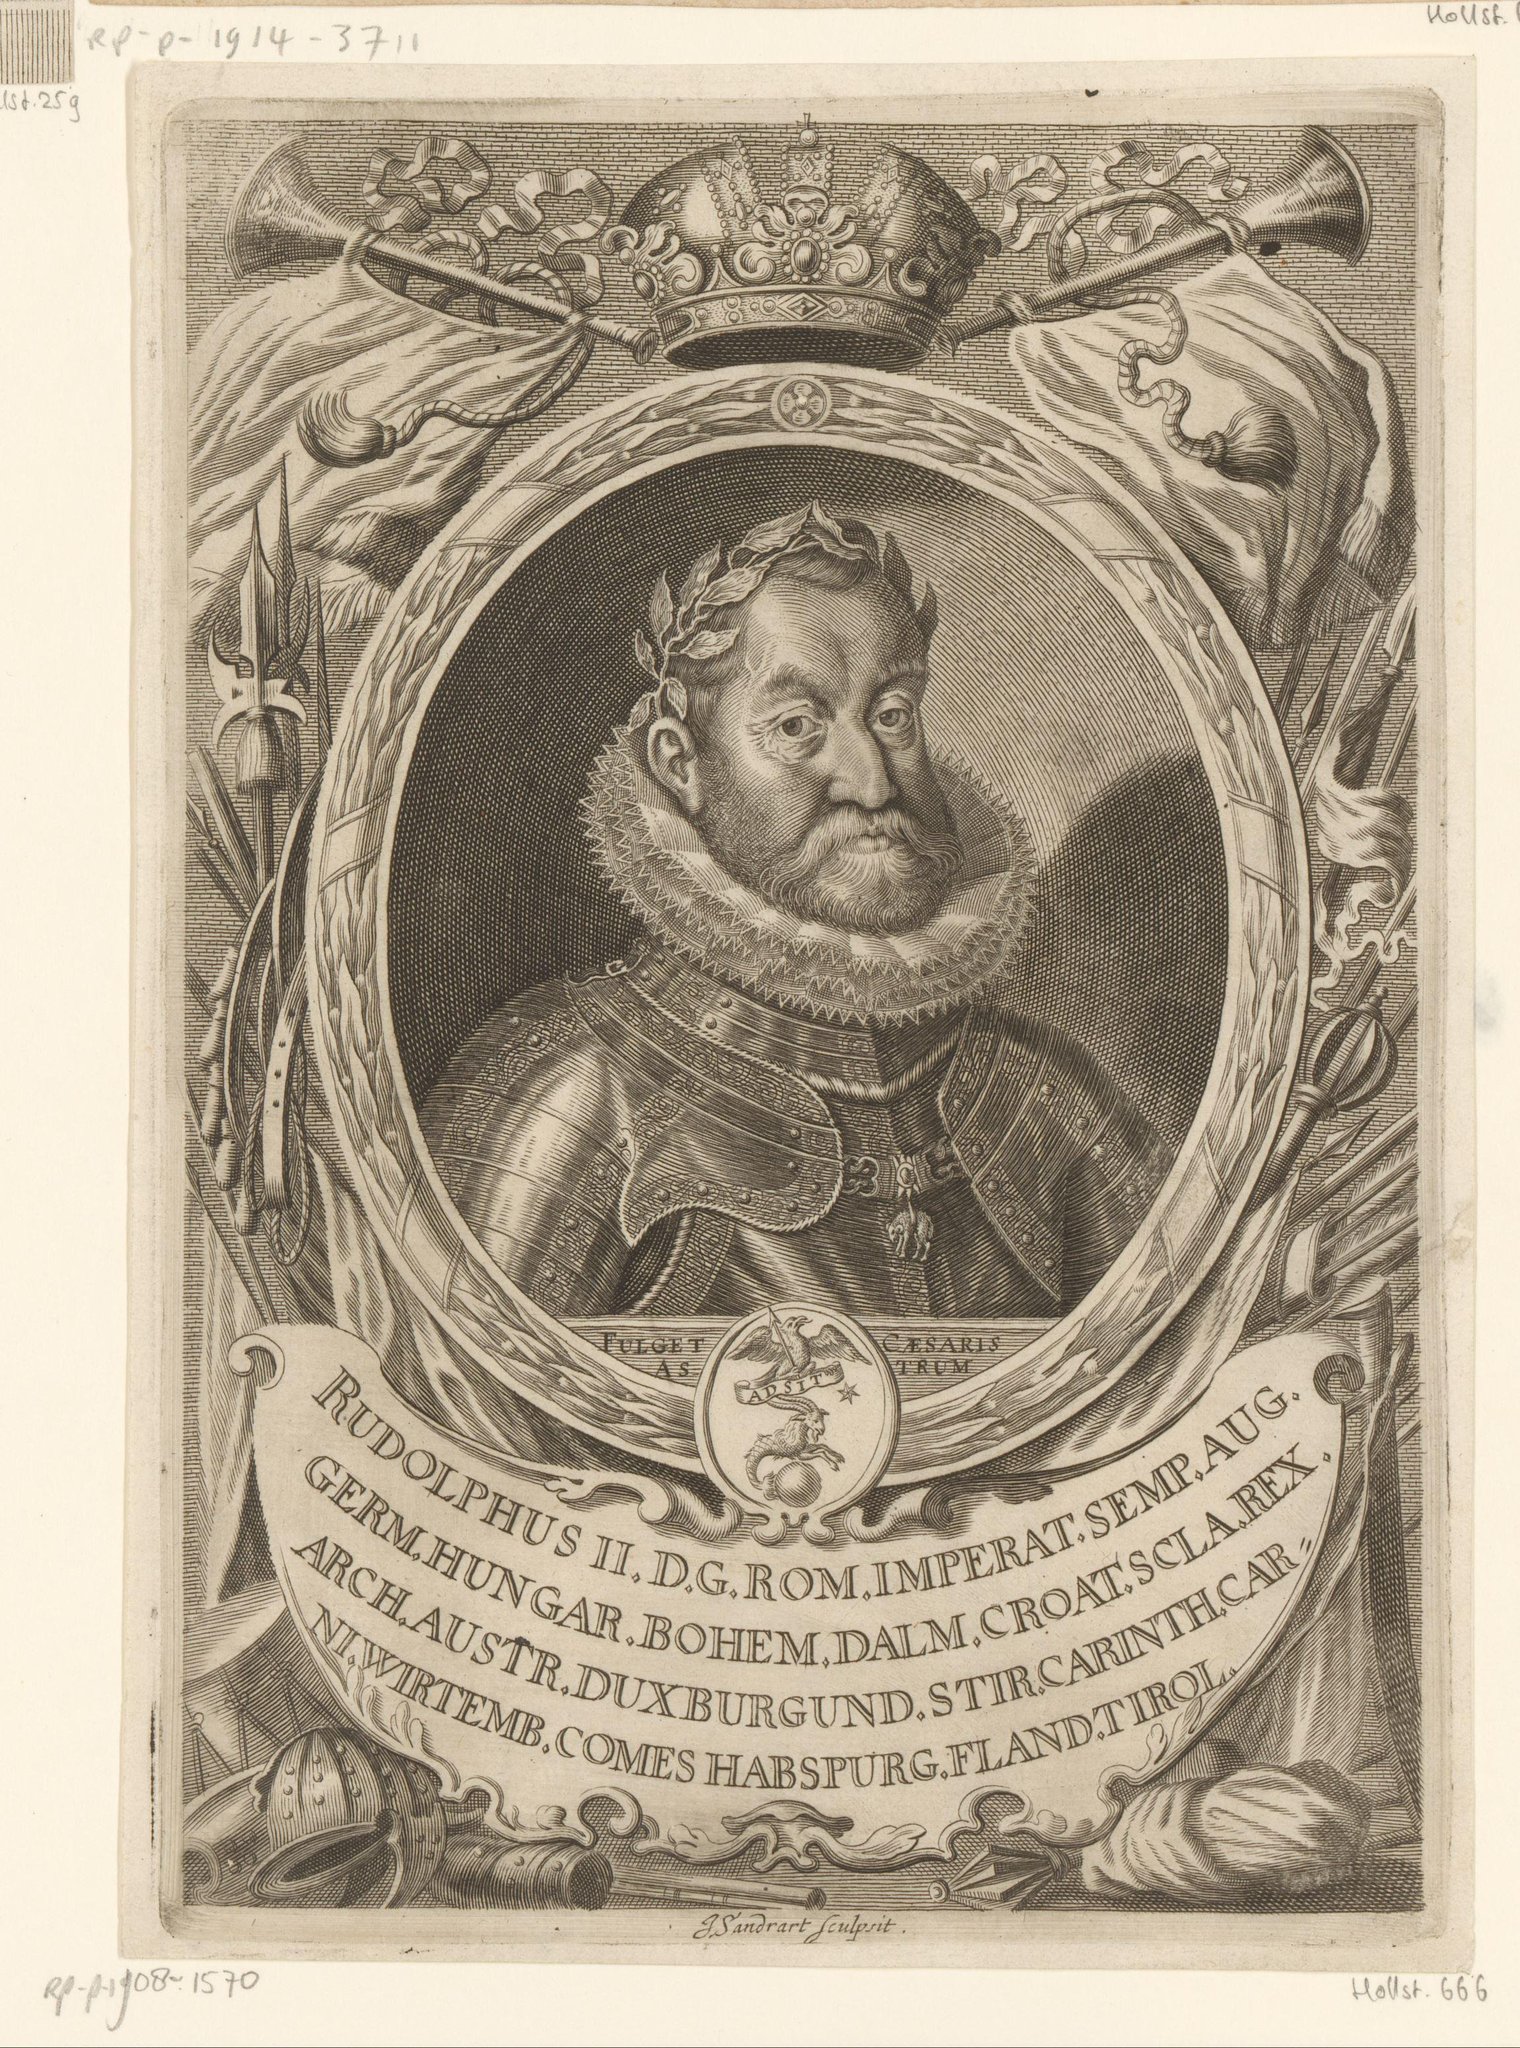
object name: print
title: Portret van Rudolf II van Habsburg, Duits keizer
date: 1671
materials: paper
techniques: engraving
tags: prague, rudolf ii van habsburg (duits keizer), historical persons, insignia and symbols of sovereignty (crown, diadem, sceptre, orb, seal, standard, cloak, pectoral)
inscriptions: collector's mark: Lugt 2228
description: Prent ook gebruikt in: Wickelmann, J.J. Oldenburgische Friedens- und benachbarten Örter Kriegshandlungen. Oldenburg: H.E. Zimmer, 1671.